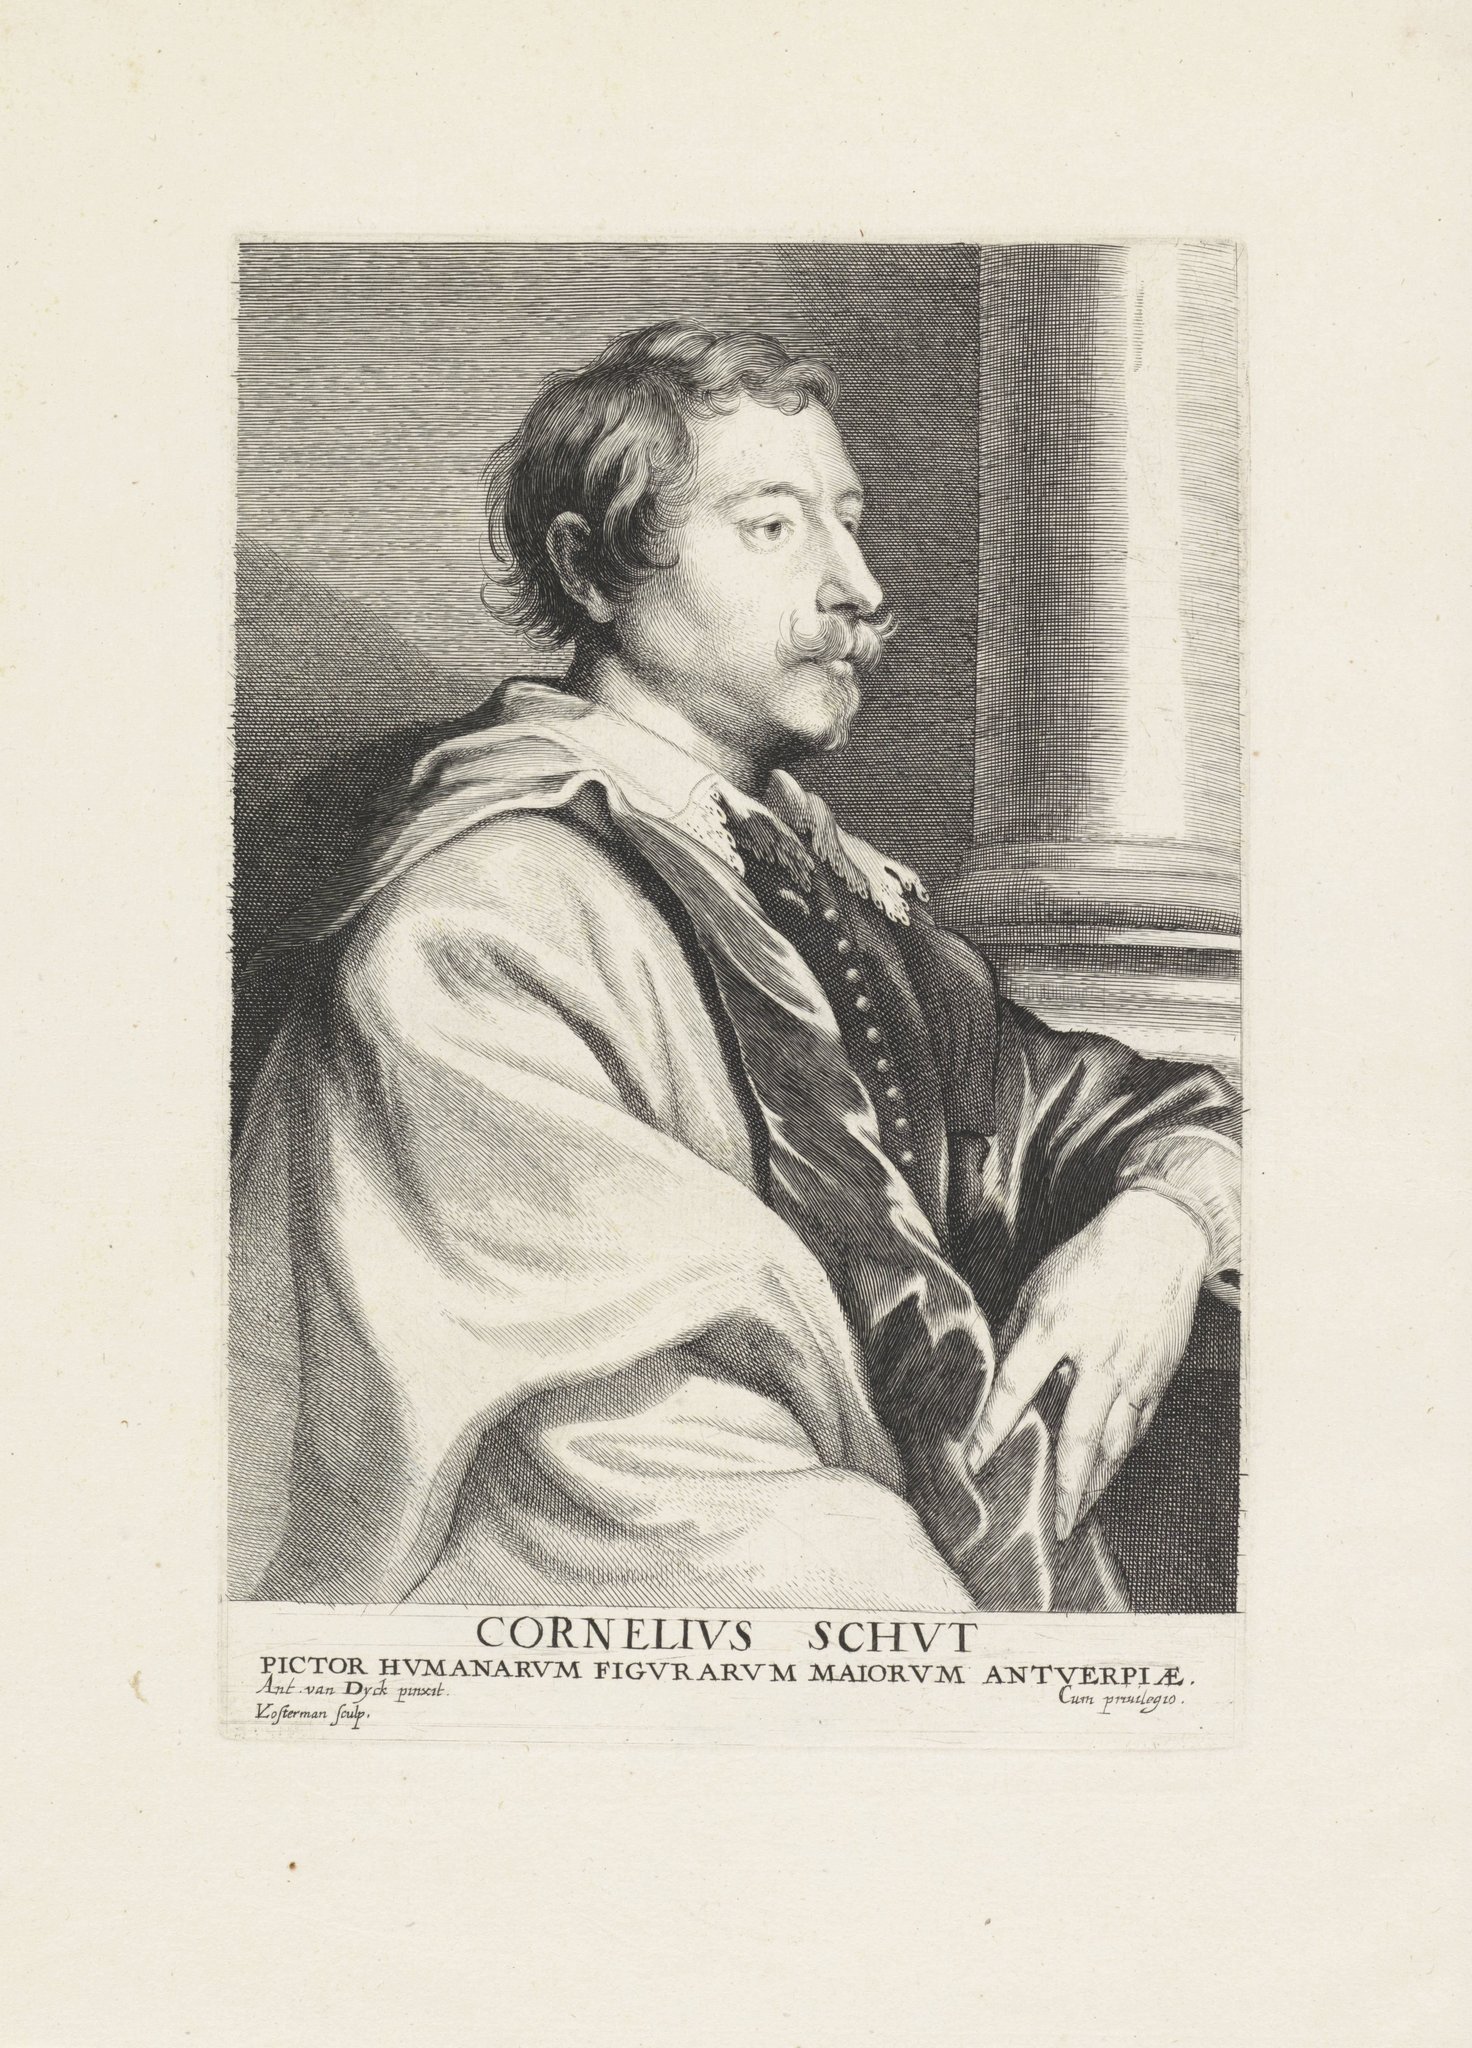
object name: print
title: Iconographie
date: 1645-1646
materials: paper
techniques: engraving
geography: antwerp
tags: antwerp, print maker, draughtsman, cornelis schut (i)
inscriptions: collector's mark: Lugt 2760, collector's mark: Lugt 2166, collector's mark: Lugt 2228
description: Prent gebruikt voor: Icones principum, virorum doctorum, pictorum, chalcographorum, statuariorum nec non amatorum pictoriae artis numero centum ab Ant. van Dyck ad vivum expressae ejusque sumptibus aeri incisae. Antwerpen: Gillis Hendricx, [1645-1646].